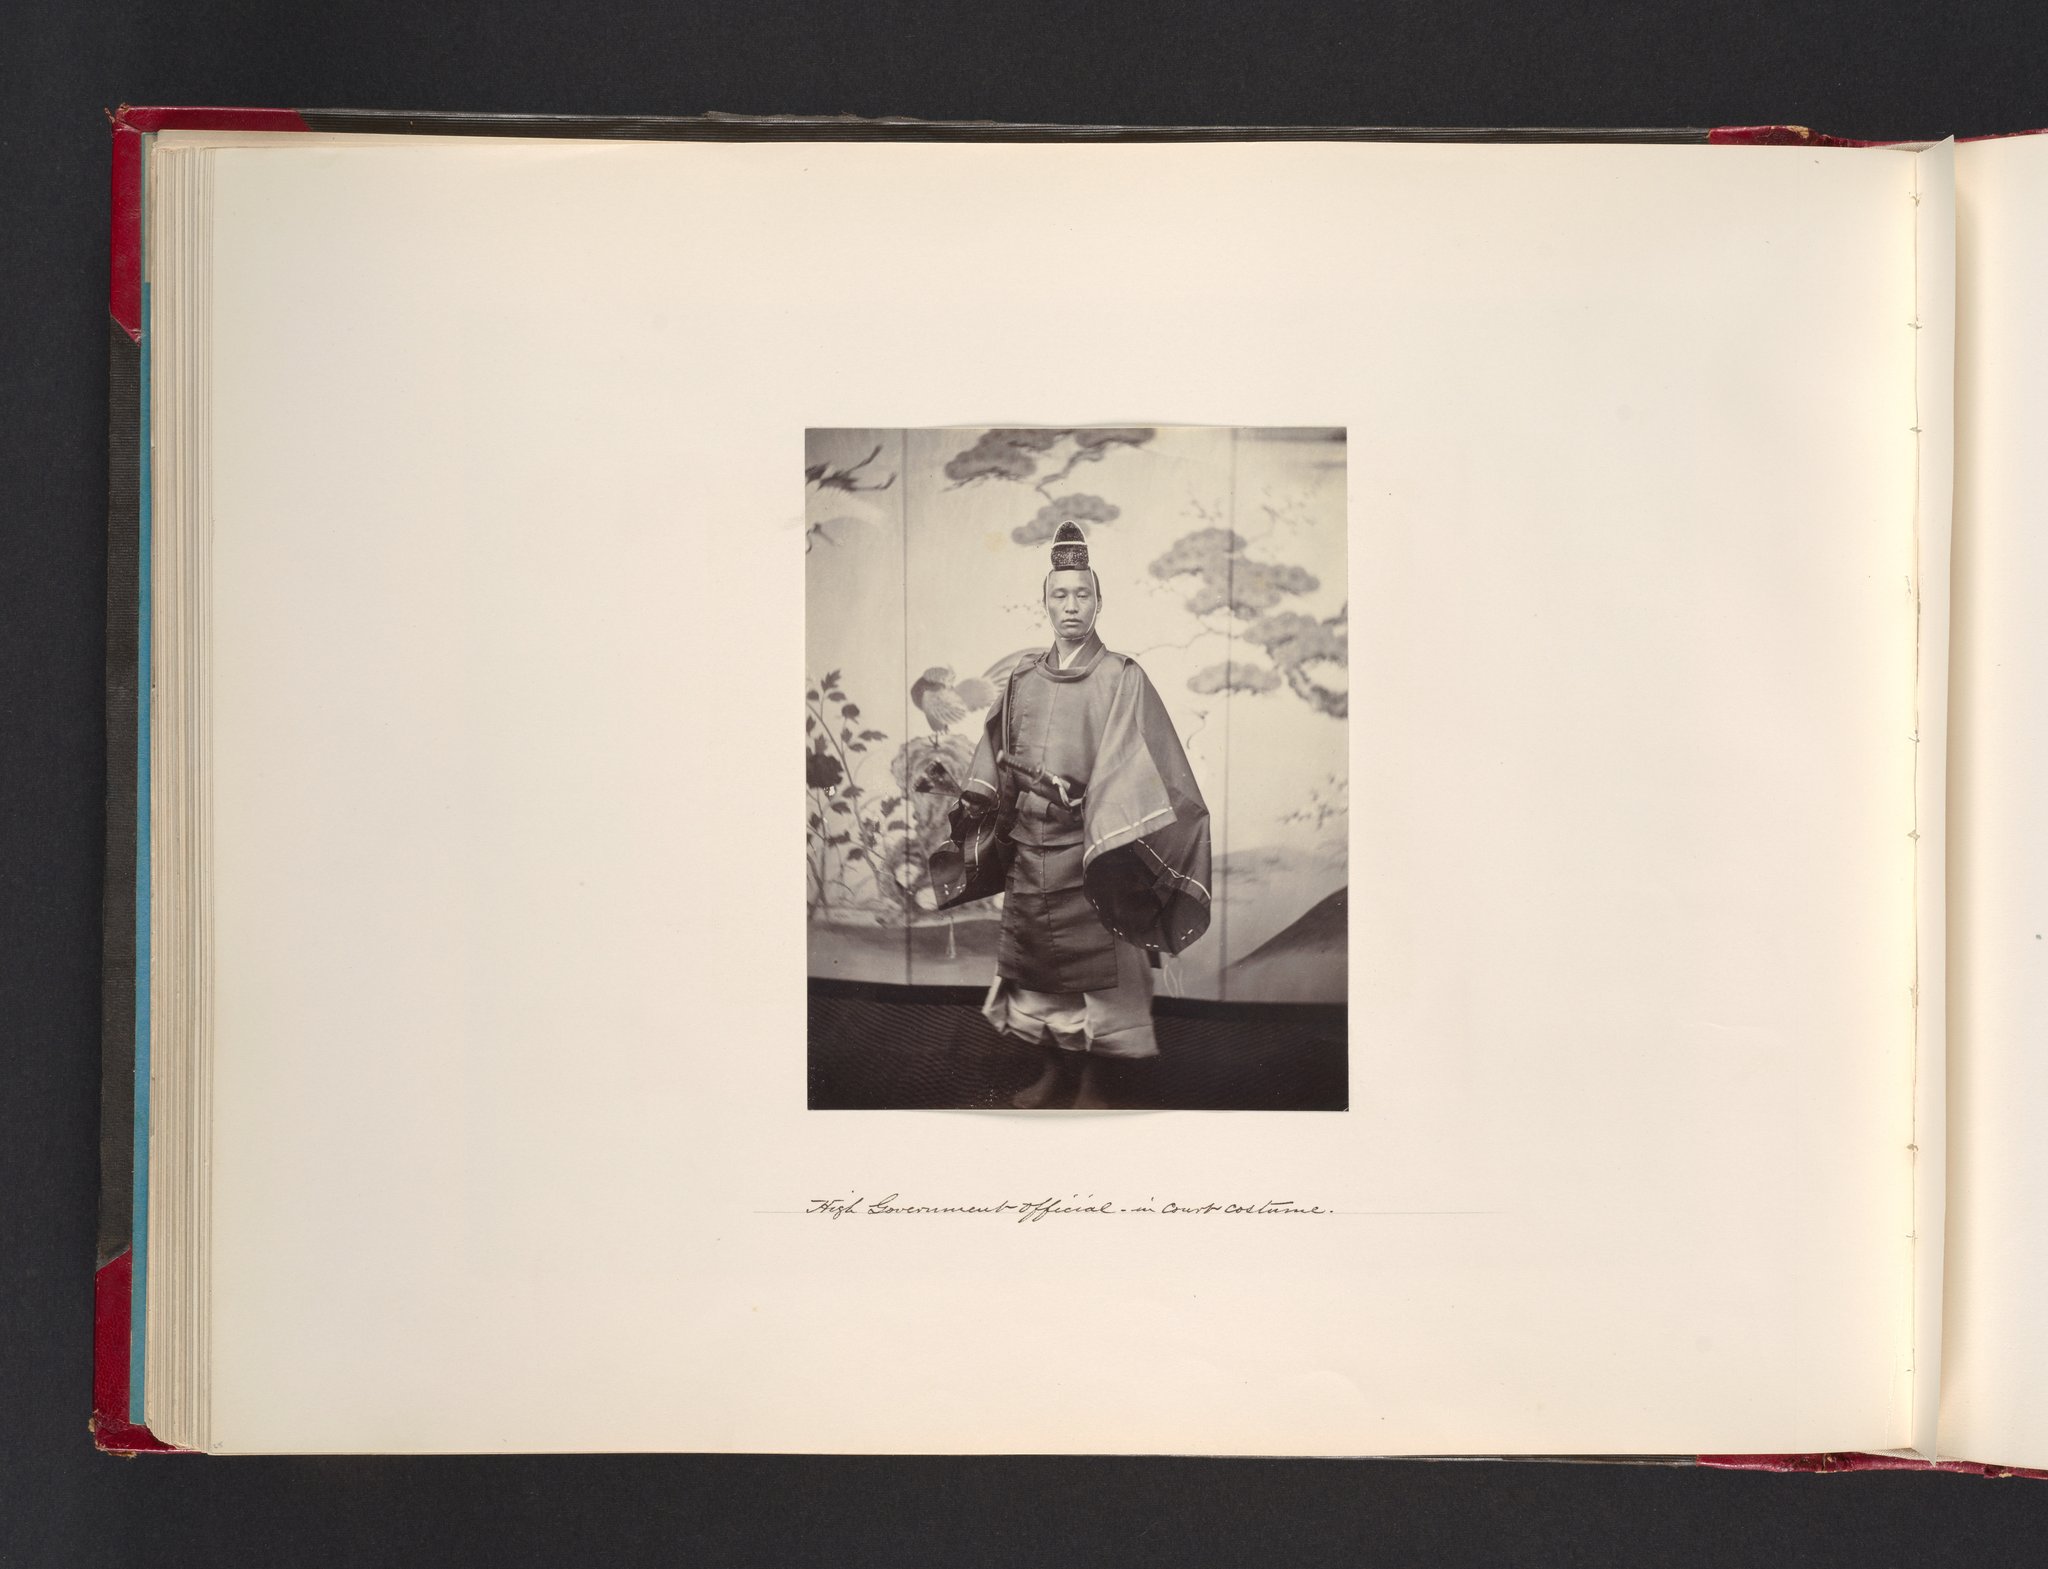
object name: photograph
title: High Government Official in Court Costume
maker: john thomson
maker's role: artist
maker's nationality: british, scottish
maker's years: 1837-1921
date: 1865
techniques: albumen silver print, glass negative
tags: men,portraits